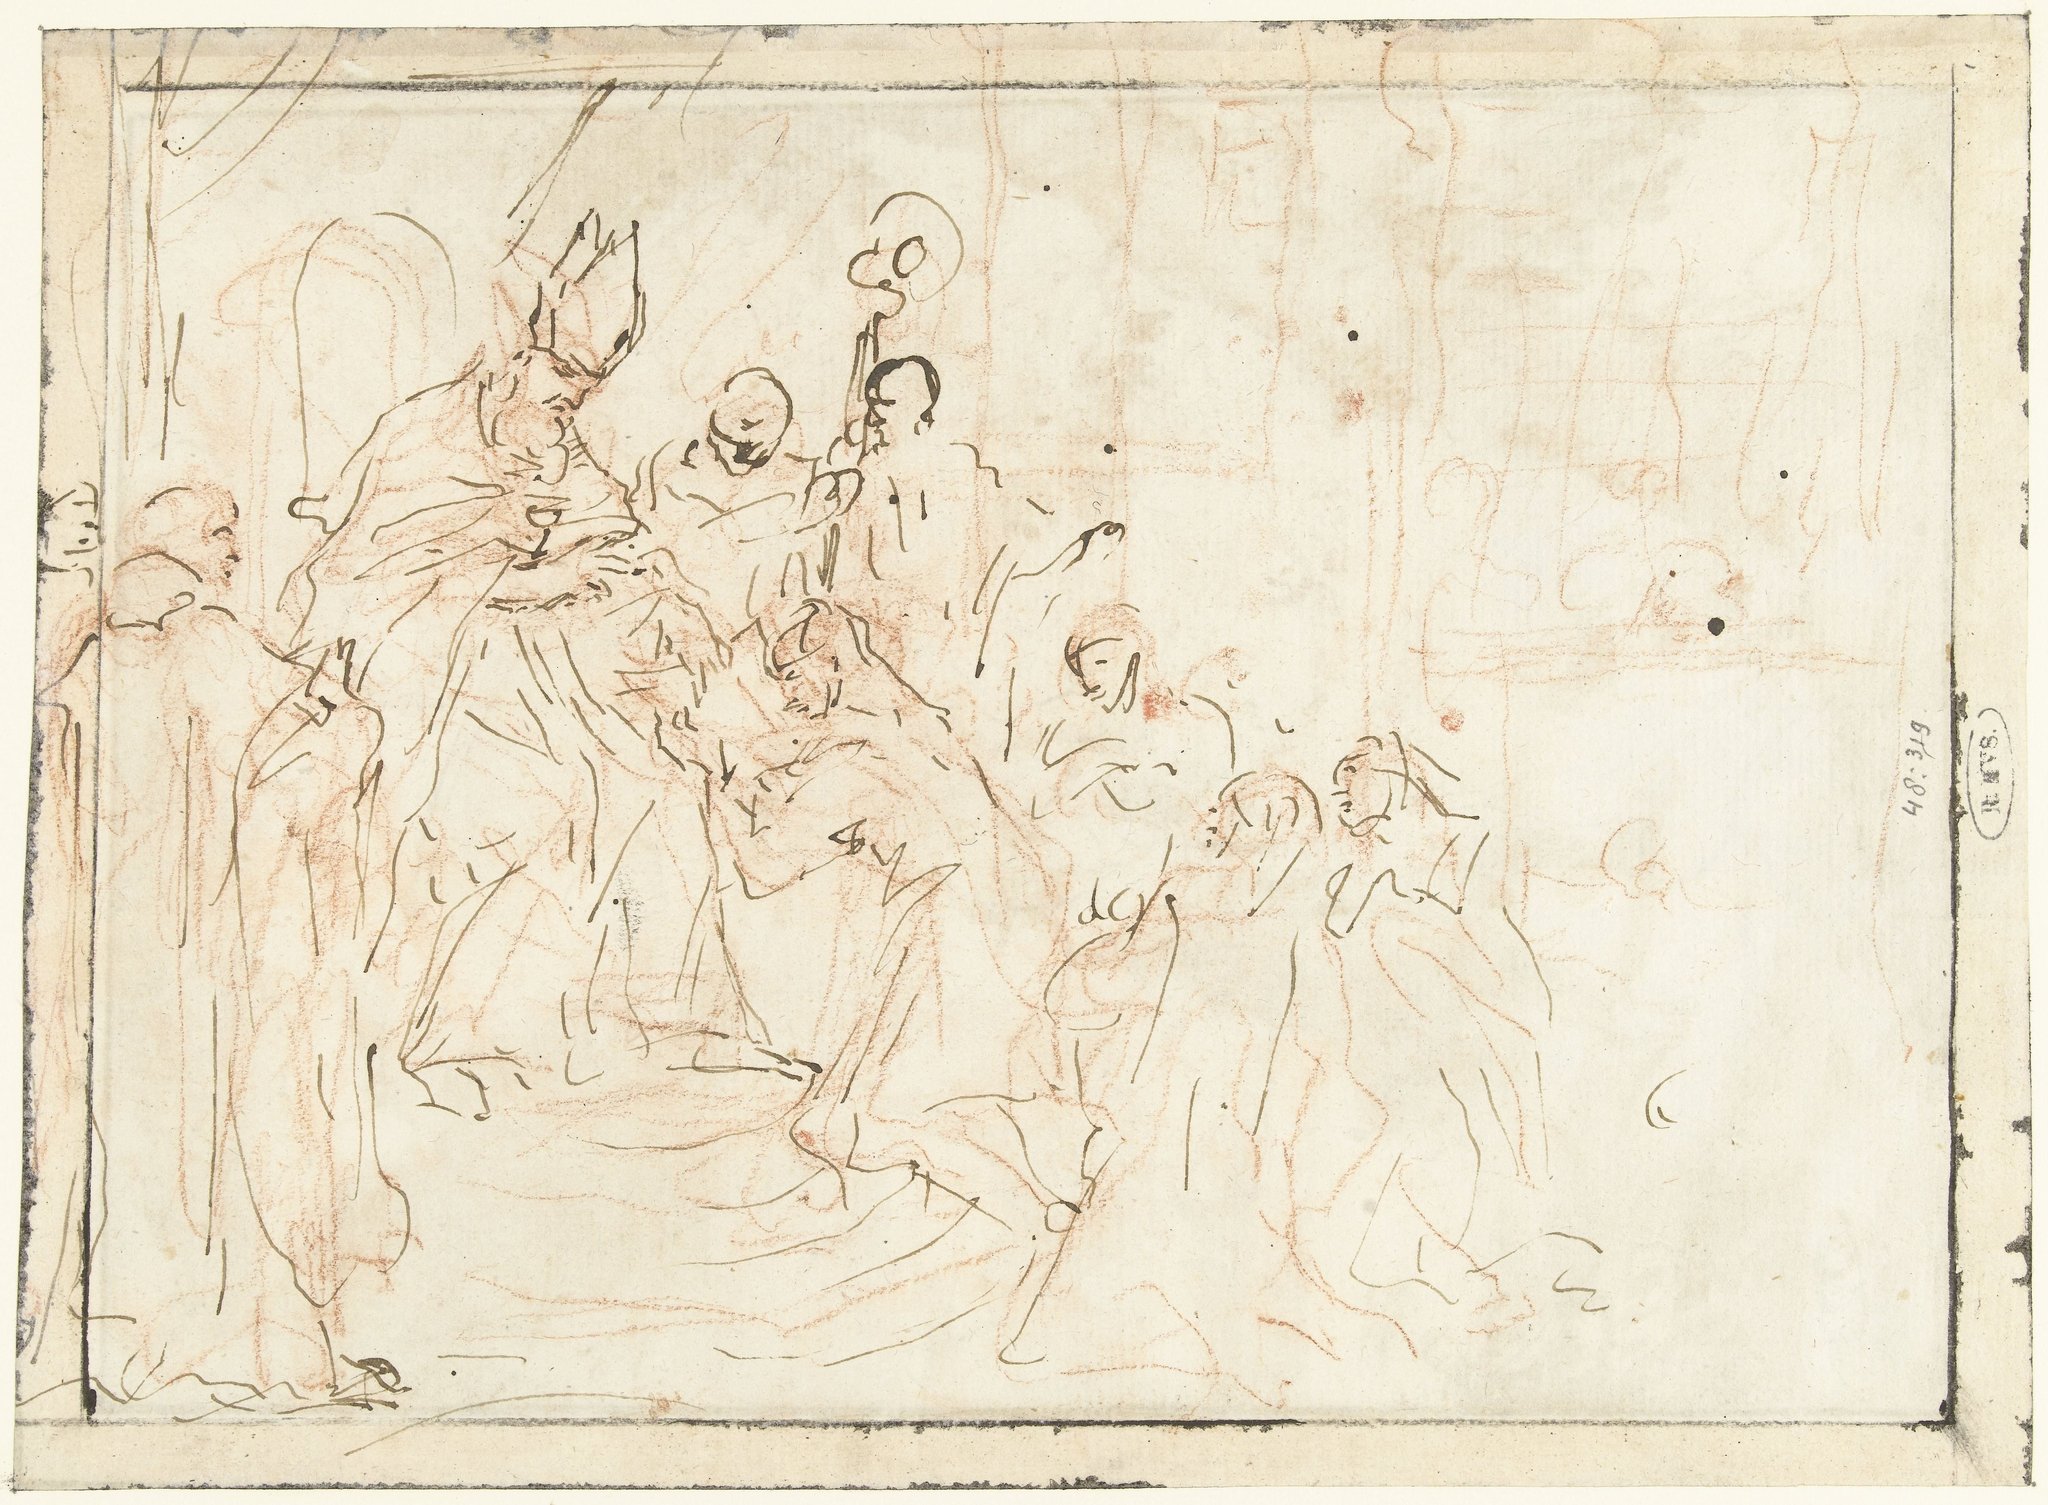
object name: drawing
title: Persoon knielend voor een bisschop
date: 1686-1779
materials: chalk, ink, paper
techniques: pen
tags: archbishop, bishop, etc. (roman catholic), receiving the rules of an order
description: Bevestiging van een ordesregel: persoon knielend voor een bisschop.